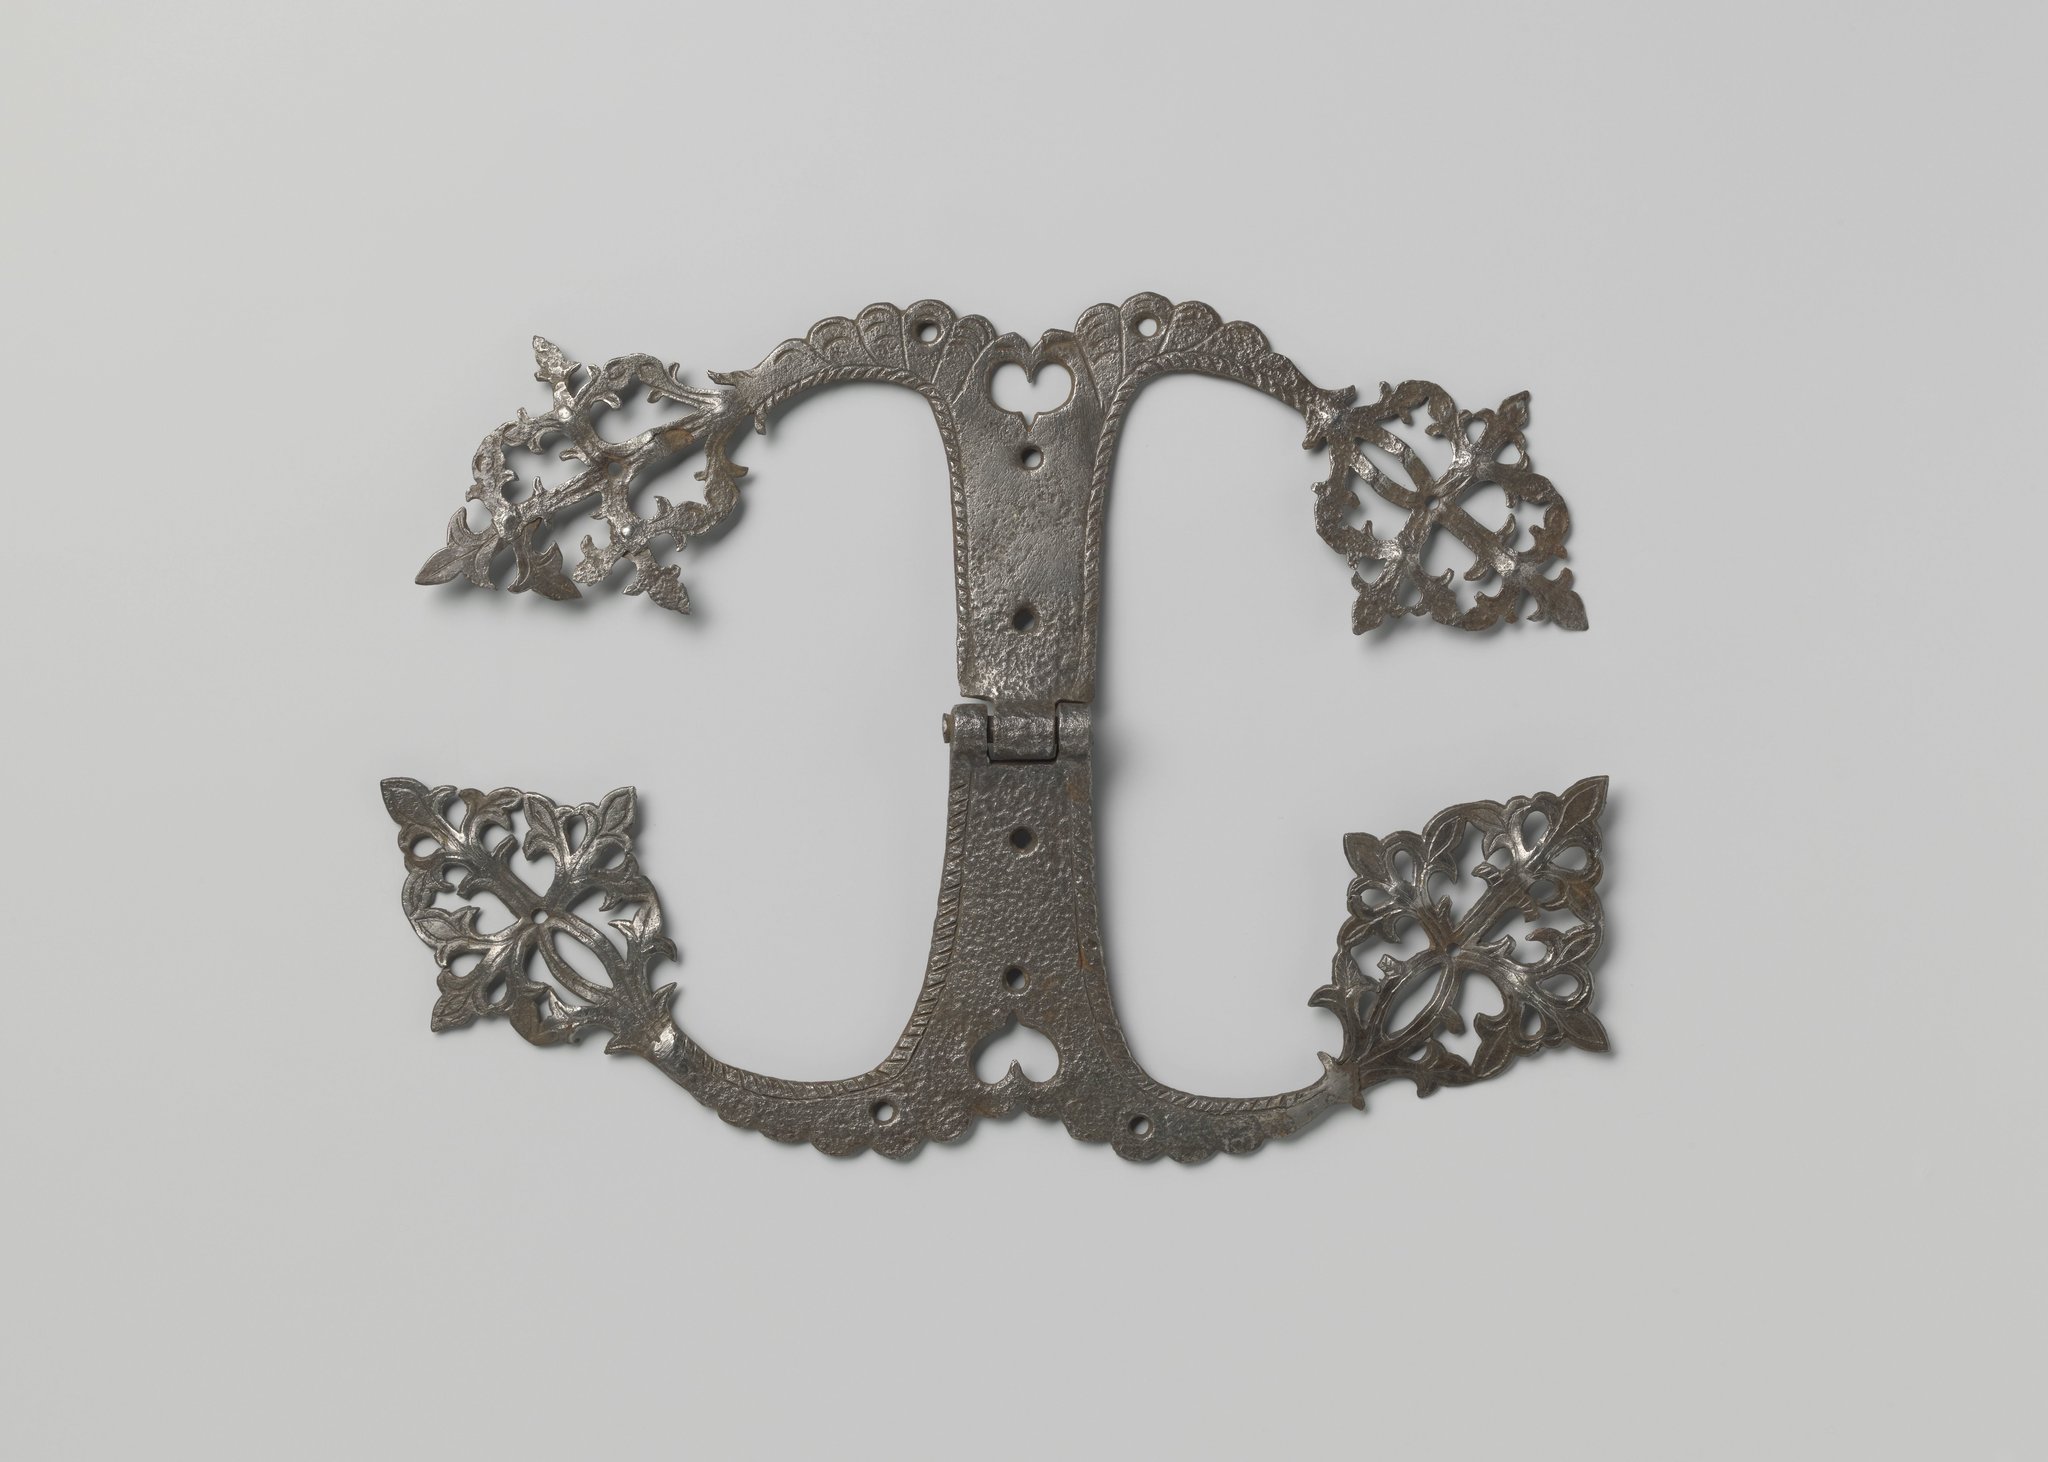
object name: scharnier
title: Scharnier, gedreven en gegraveerd.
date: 1400-1500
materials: iron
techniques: engraving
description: Een ijzeren scharnier, gedreven en gegraveerd.